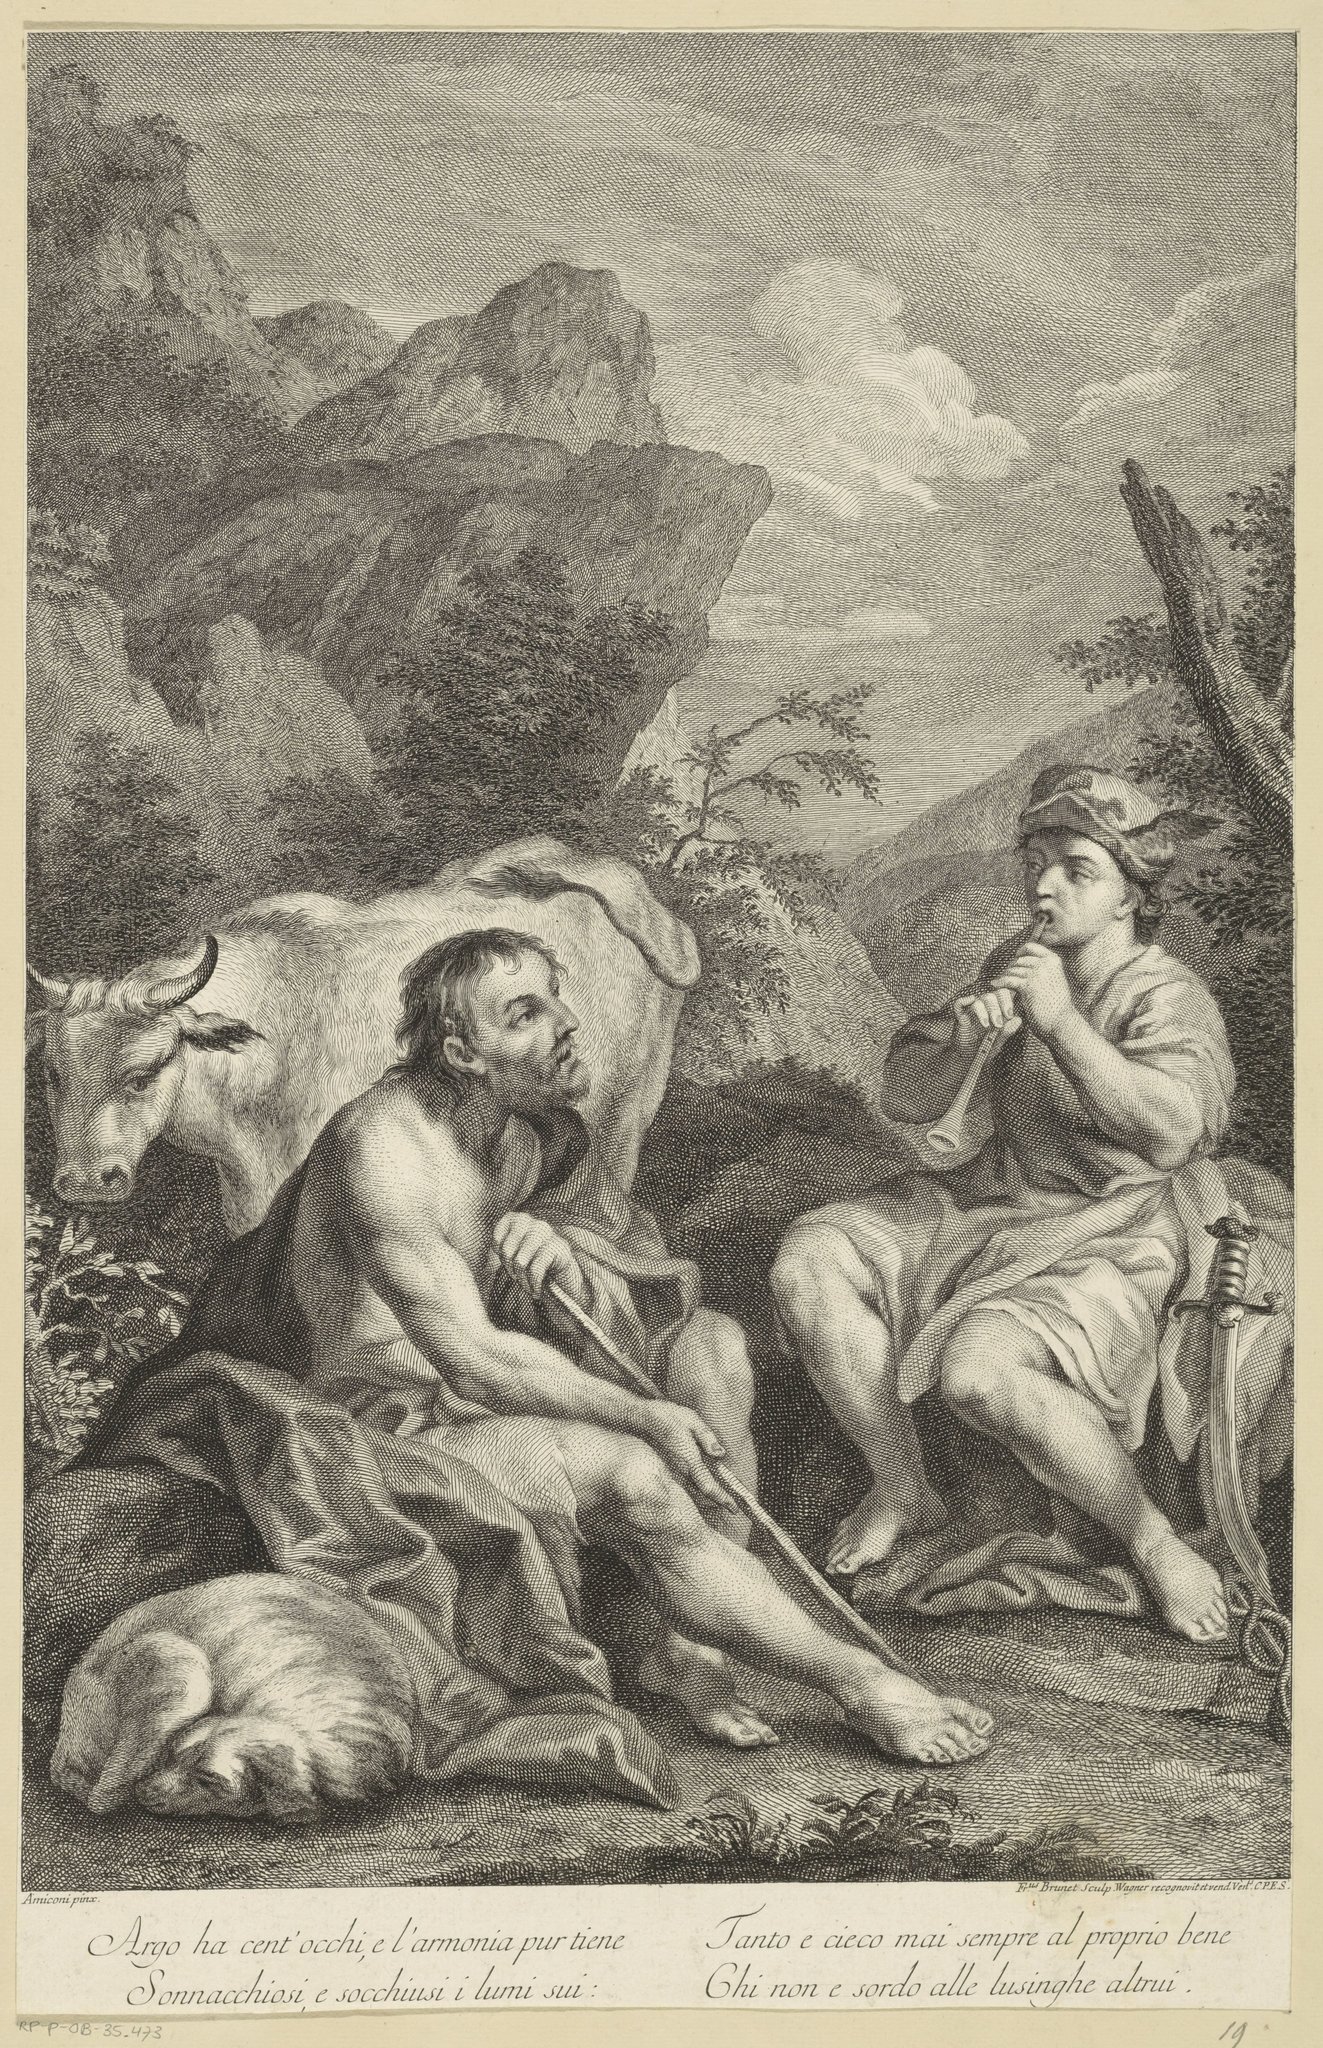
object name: print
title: Mercurius en Argus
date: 1791-1801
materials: paper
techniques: engraving, etching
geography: italy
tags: mercury lulls argus into sleep by making music, io as a cow watched by argus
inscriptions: collector's mark: Lugt 240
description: Mercurius zit rechts en speelt op een fluit. Hij probeert Argus in slaap te sussen met zijn muziek, om hem vervolgens te kunnen vermoorden. Argus zit links en past op Io in de gedaante van een koe. Naast Argus ligt een hond te slapen.